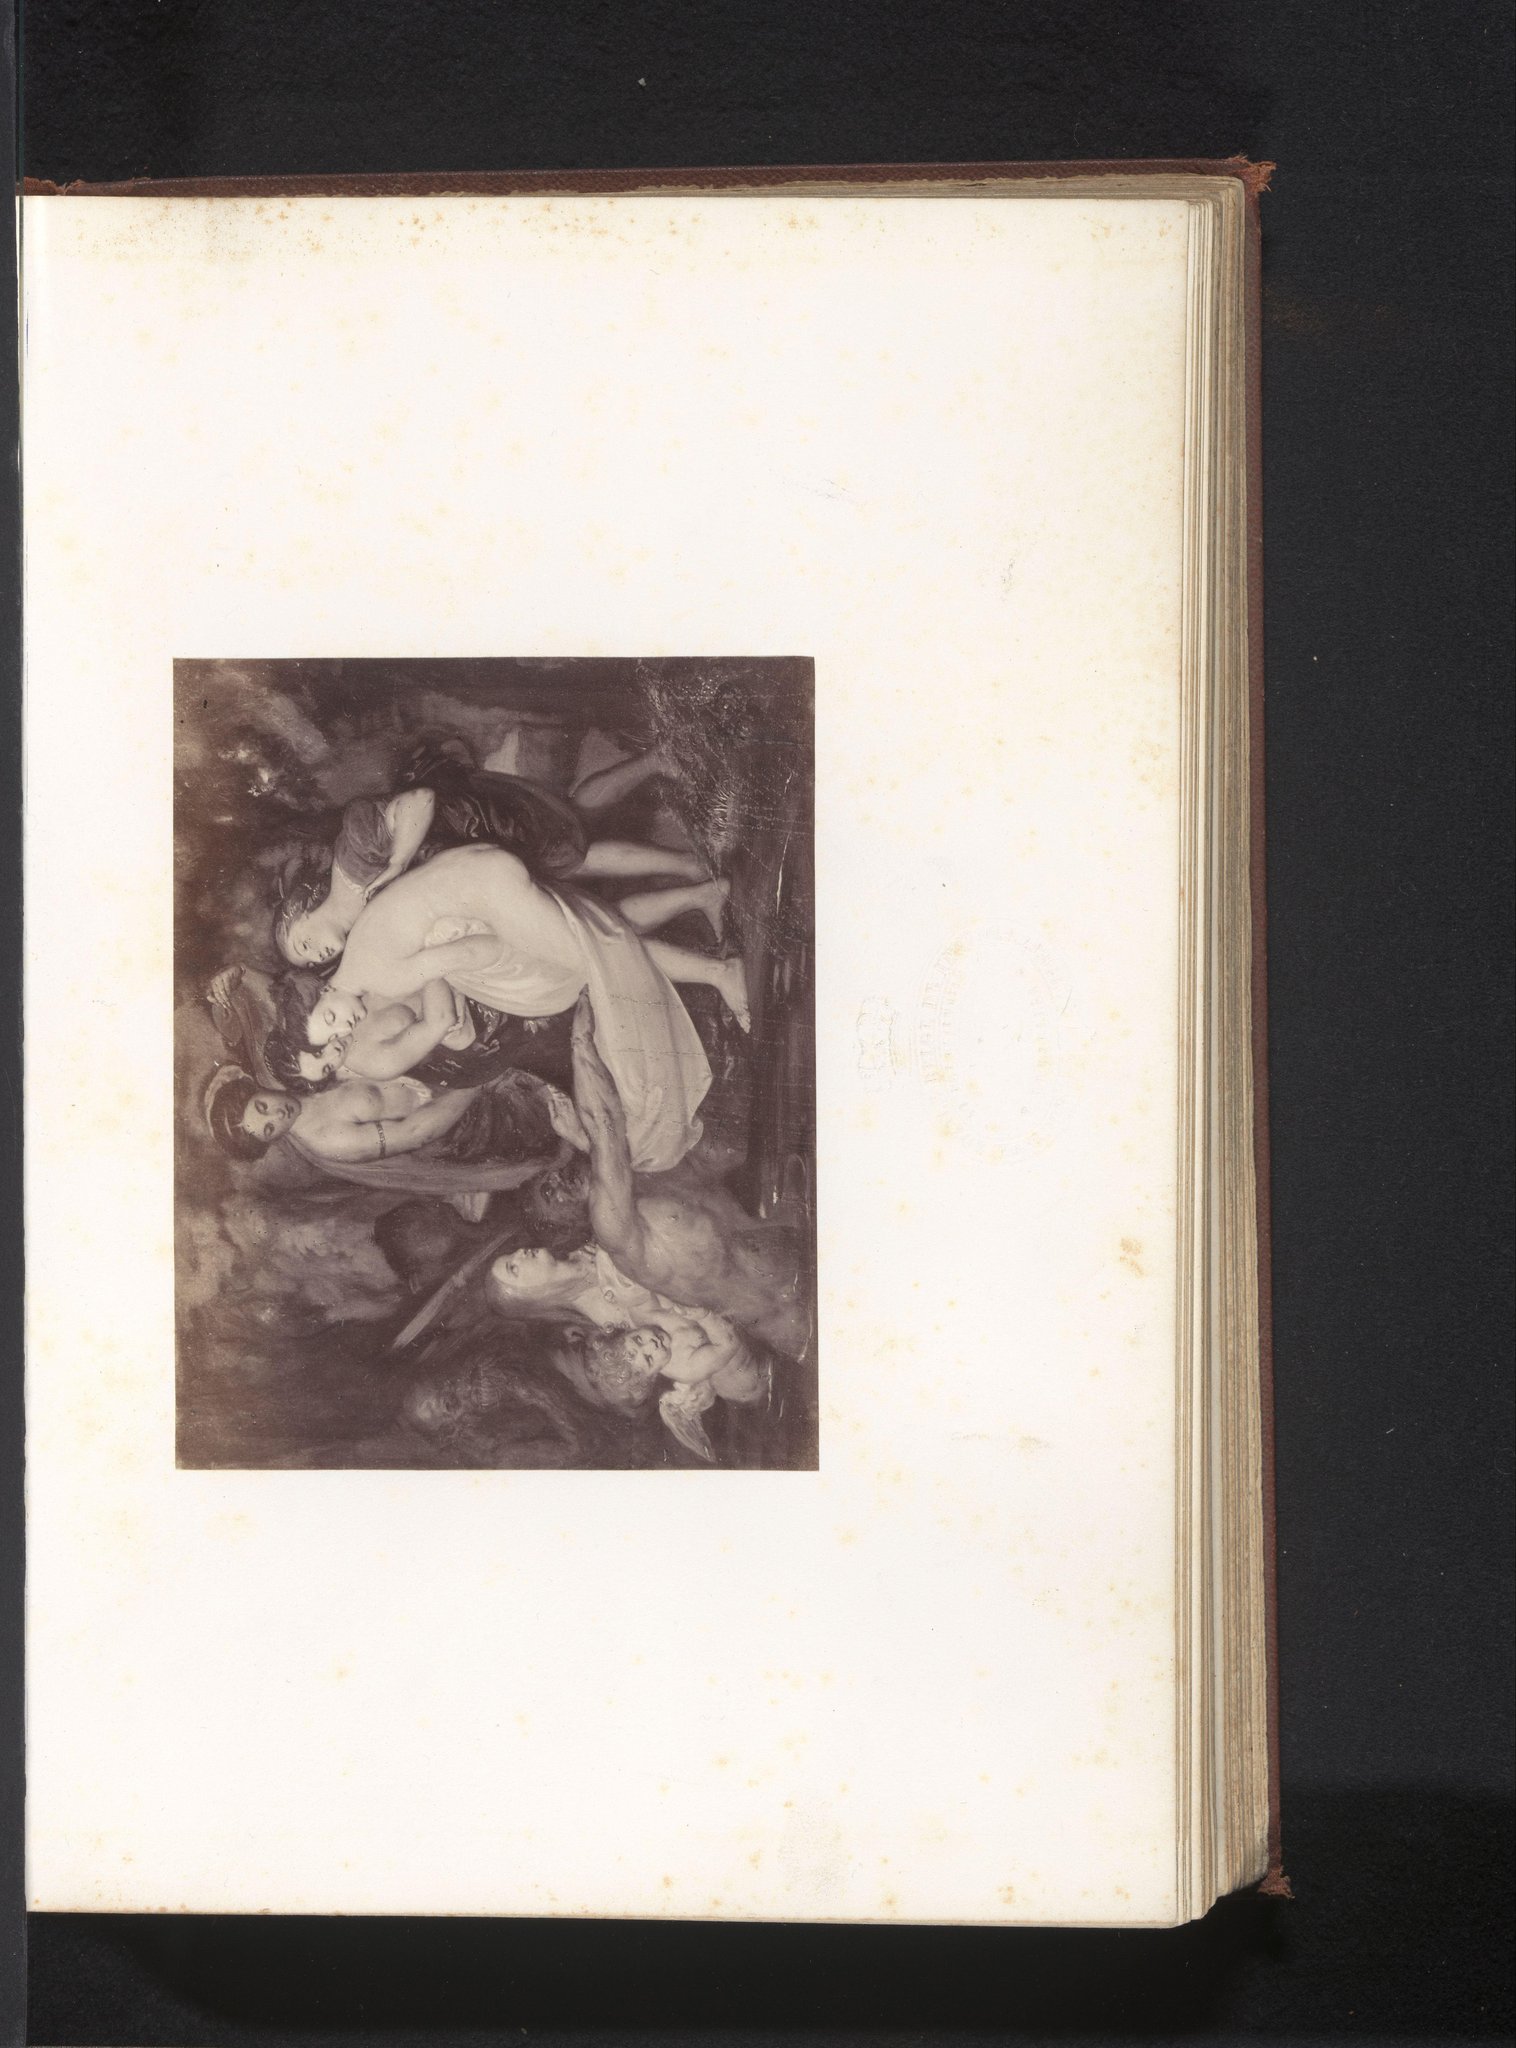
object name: photograph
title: Fotoreproductie van De grote der aarde door Antoine Wiertz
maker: edmond fierlants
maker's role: fotograaf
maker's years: 1819-1869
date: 1863-1868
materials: photographic support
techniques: albumen print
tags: giants, colossi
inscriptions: check stamp: ‘SOCIÉTÉ ROYALE BELGE DE PHOTOGRAPHIE/ 69, RUE KEYENVELD/ BRUXELLES’